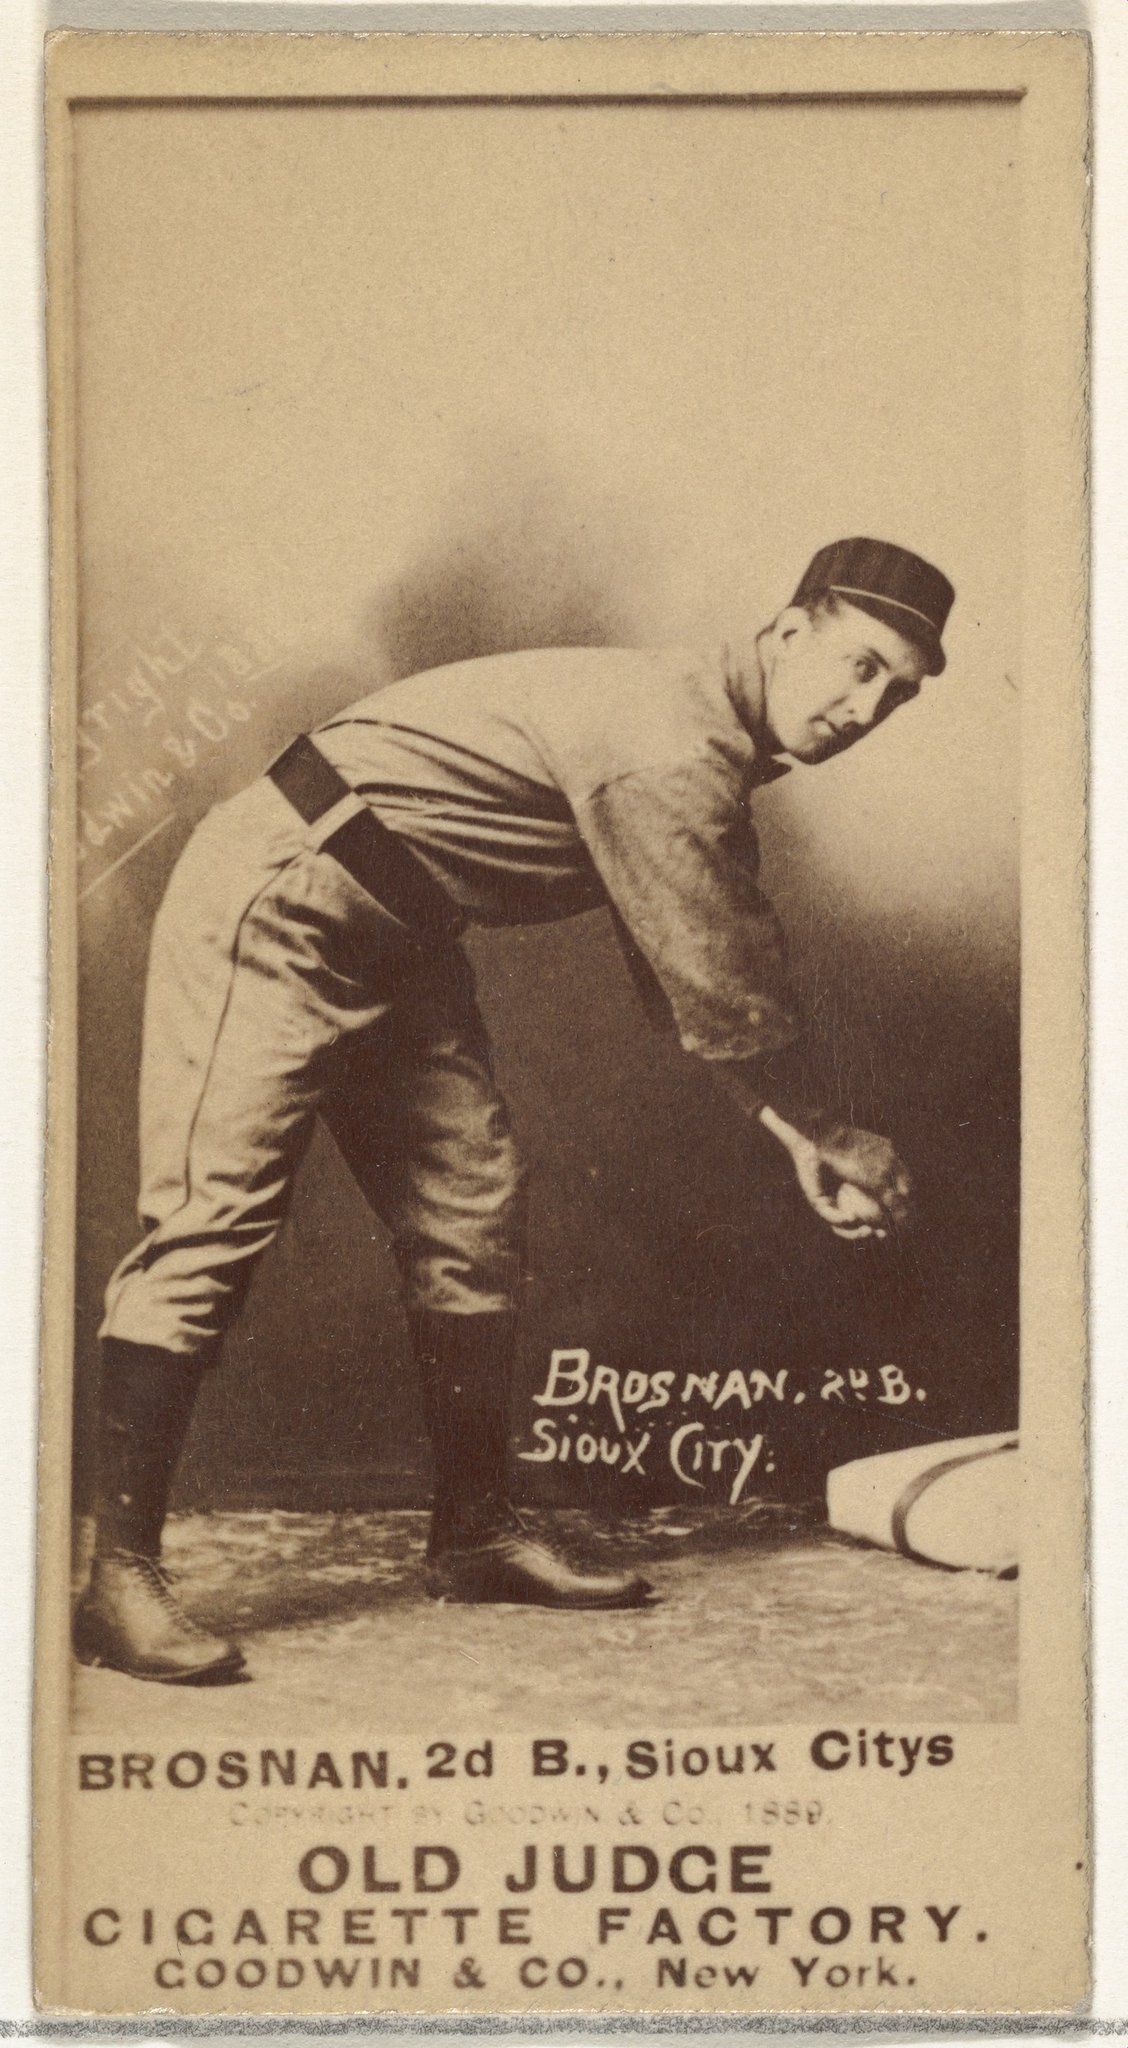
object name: baseball card, photograph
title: Timothy J. Brosnan, 2nd Base, Sioux City Corn Huskers, from the Old Judge series (N172) for Old Judge Cigarettes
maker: goodwin & company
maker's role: publisher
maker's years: 1850-1950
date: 1889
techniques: albumen silver print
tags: men,portraits,baseball,athletes